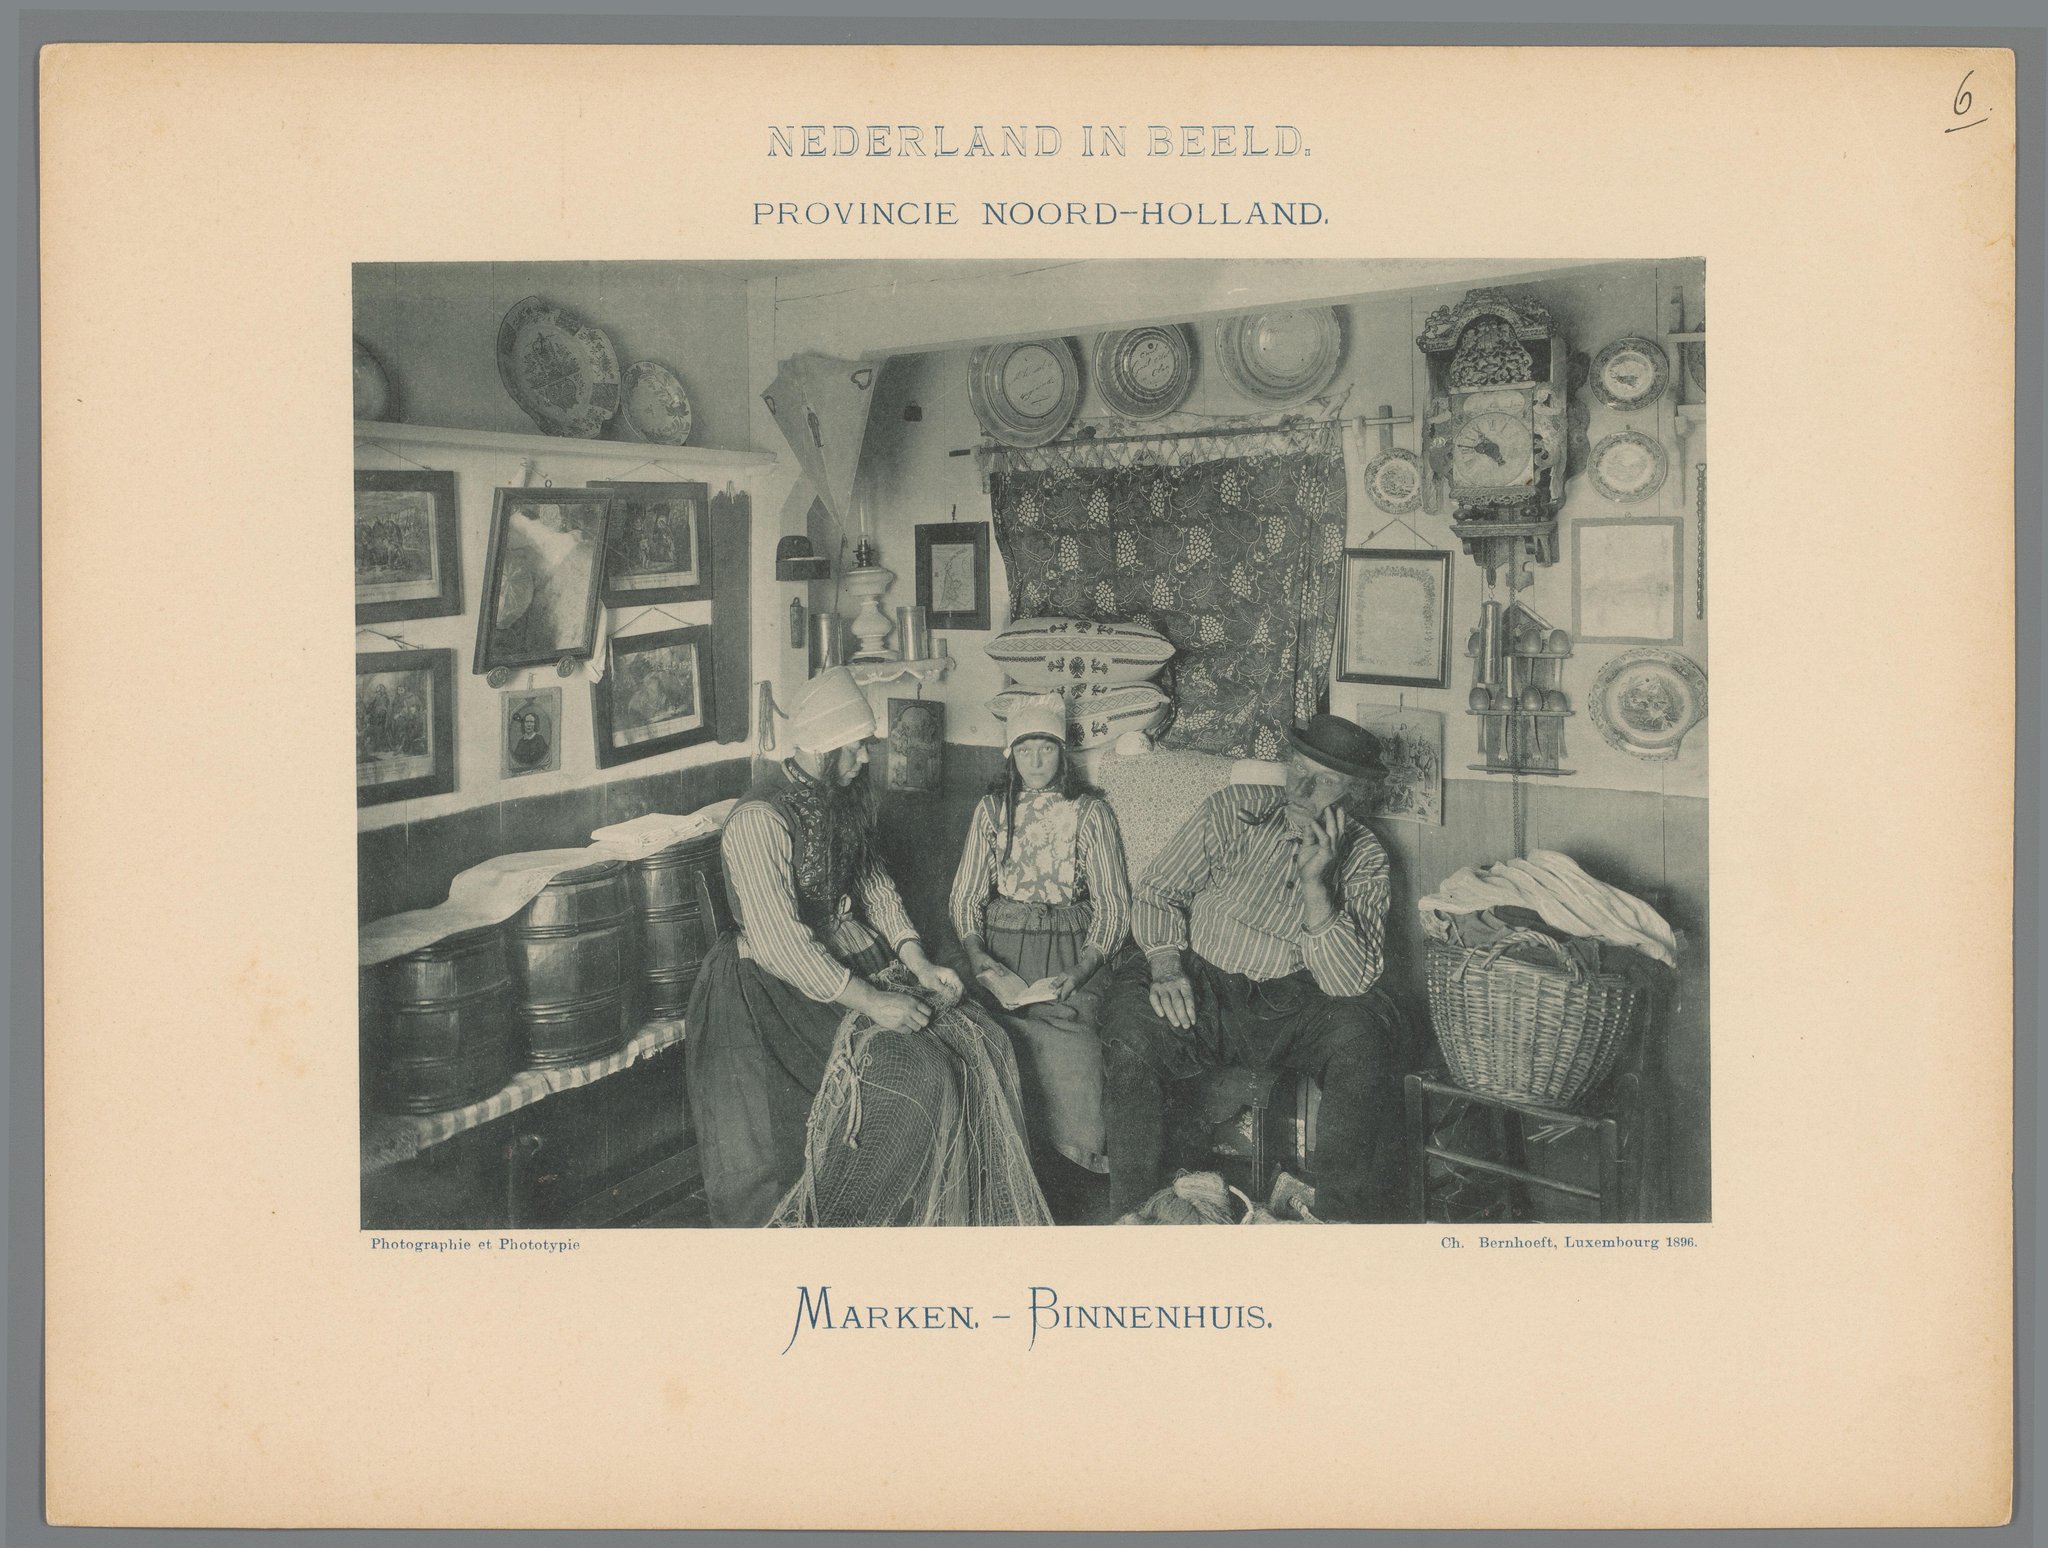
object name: photomechanical print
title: Marken. Binnenhuis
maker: charles bernhoeft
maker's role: publisher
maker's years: 1859-1933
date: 1896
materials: cardboard, paper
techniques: photograph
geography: marken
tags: parents with their children, historical persons, interior ~ representation of a building, fisherman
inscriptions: number: ‘6.’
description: Deze prent maakt deel uit van een omslag met 43 lichtdrukken op 43 bladen.